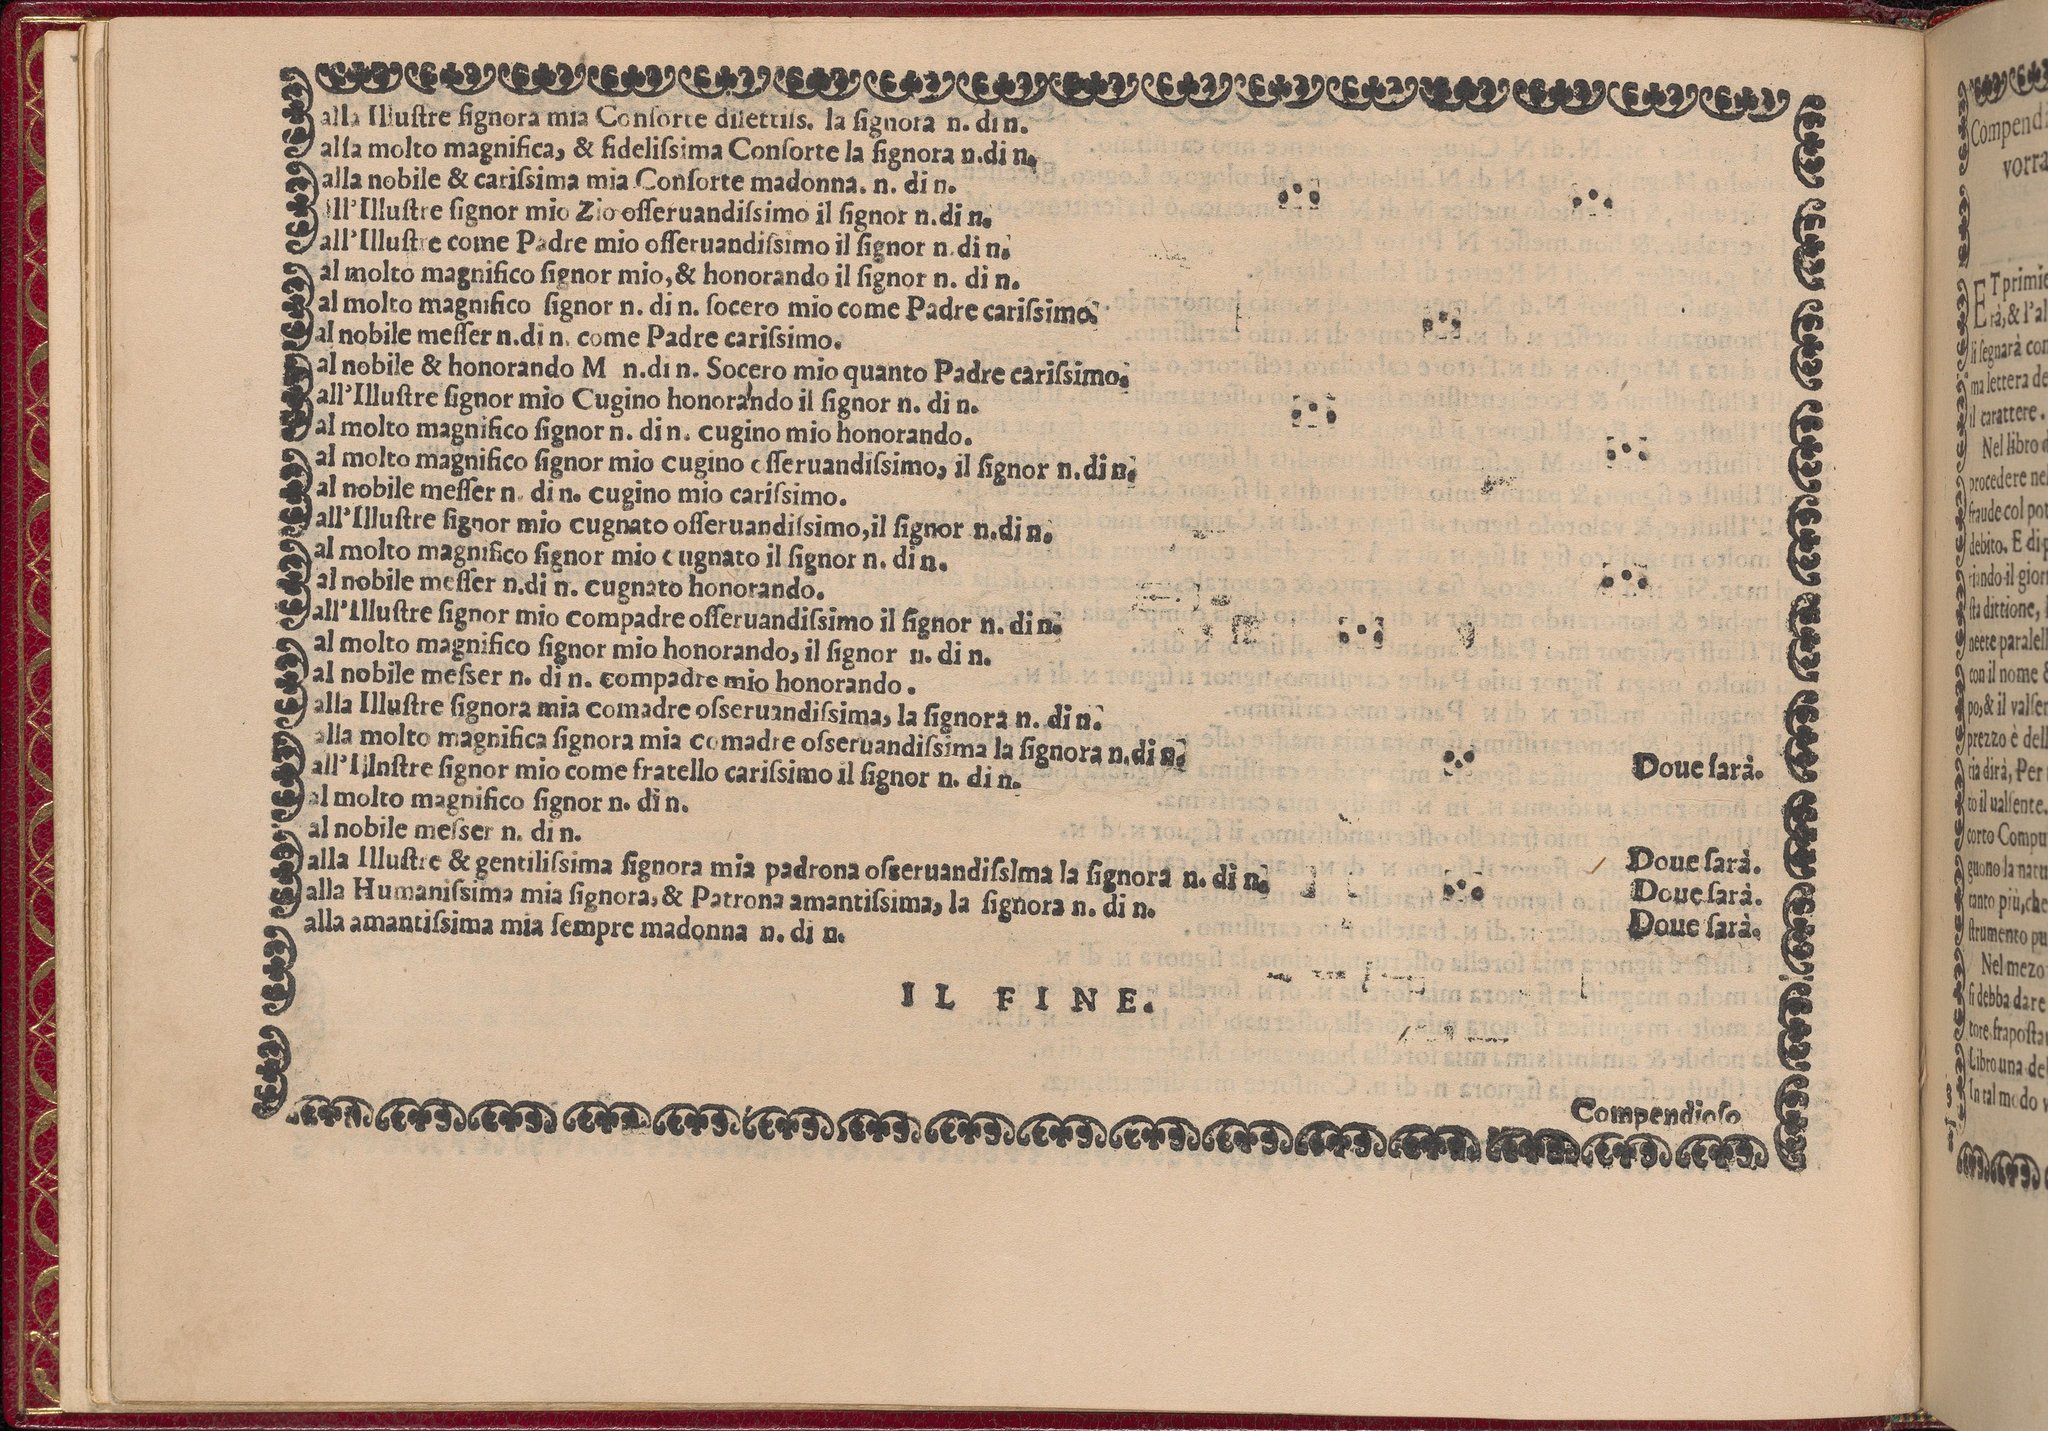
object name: book print ornament architecture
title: Ghirlanda: Di sei vaghi fiori scielti da piu famosi Giardini d'Italia, page 6 (verso)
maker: pietro paulo tozzi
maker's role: designer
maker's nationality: italian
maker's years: 1593-1628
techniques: drawing, etching